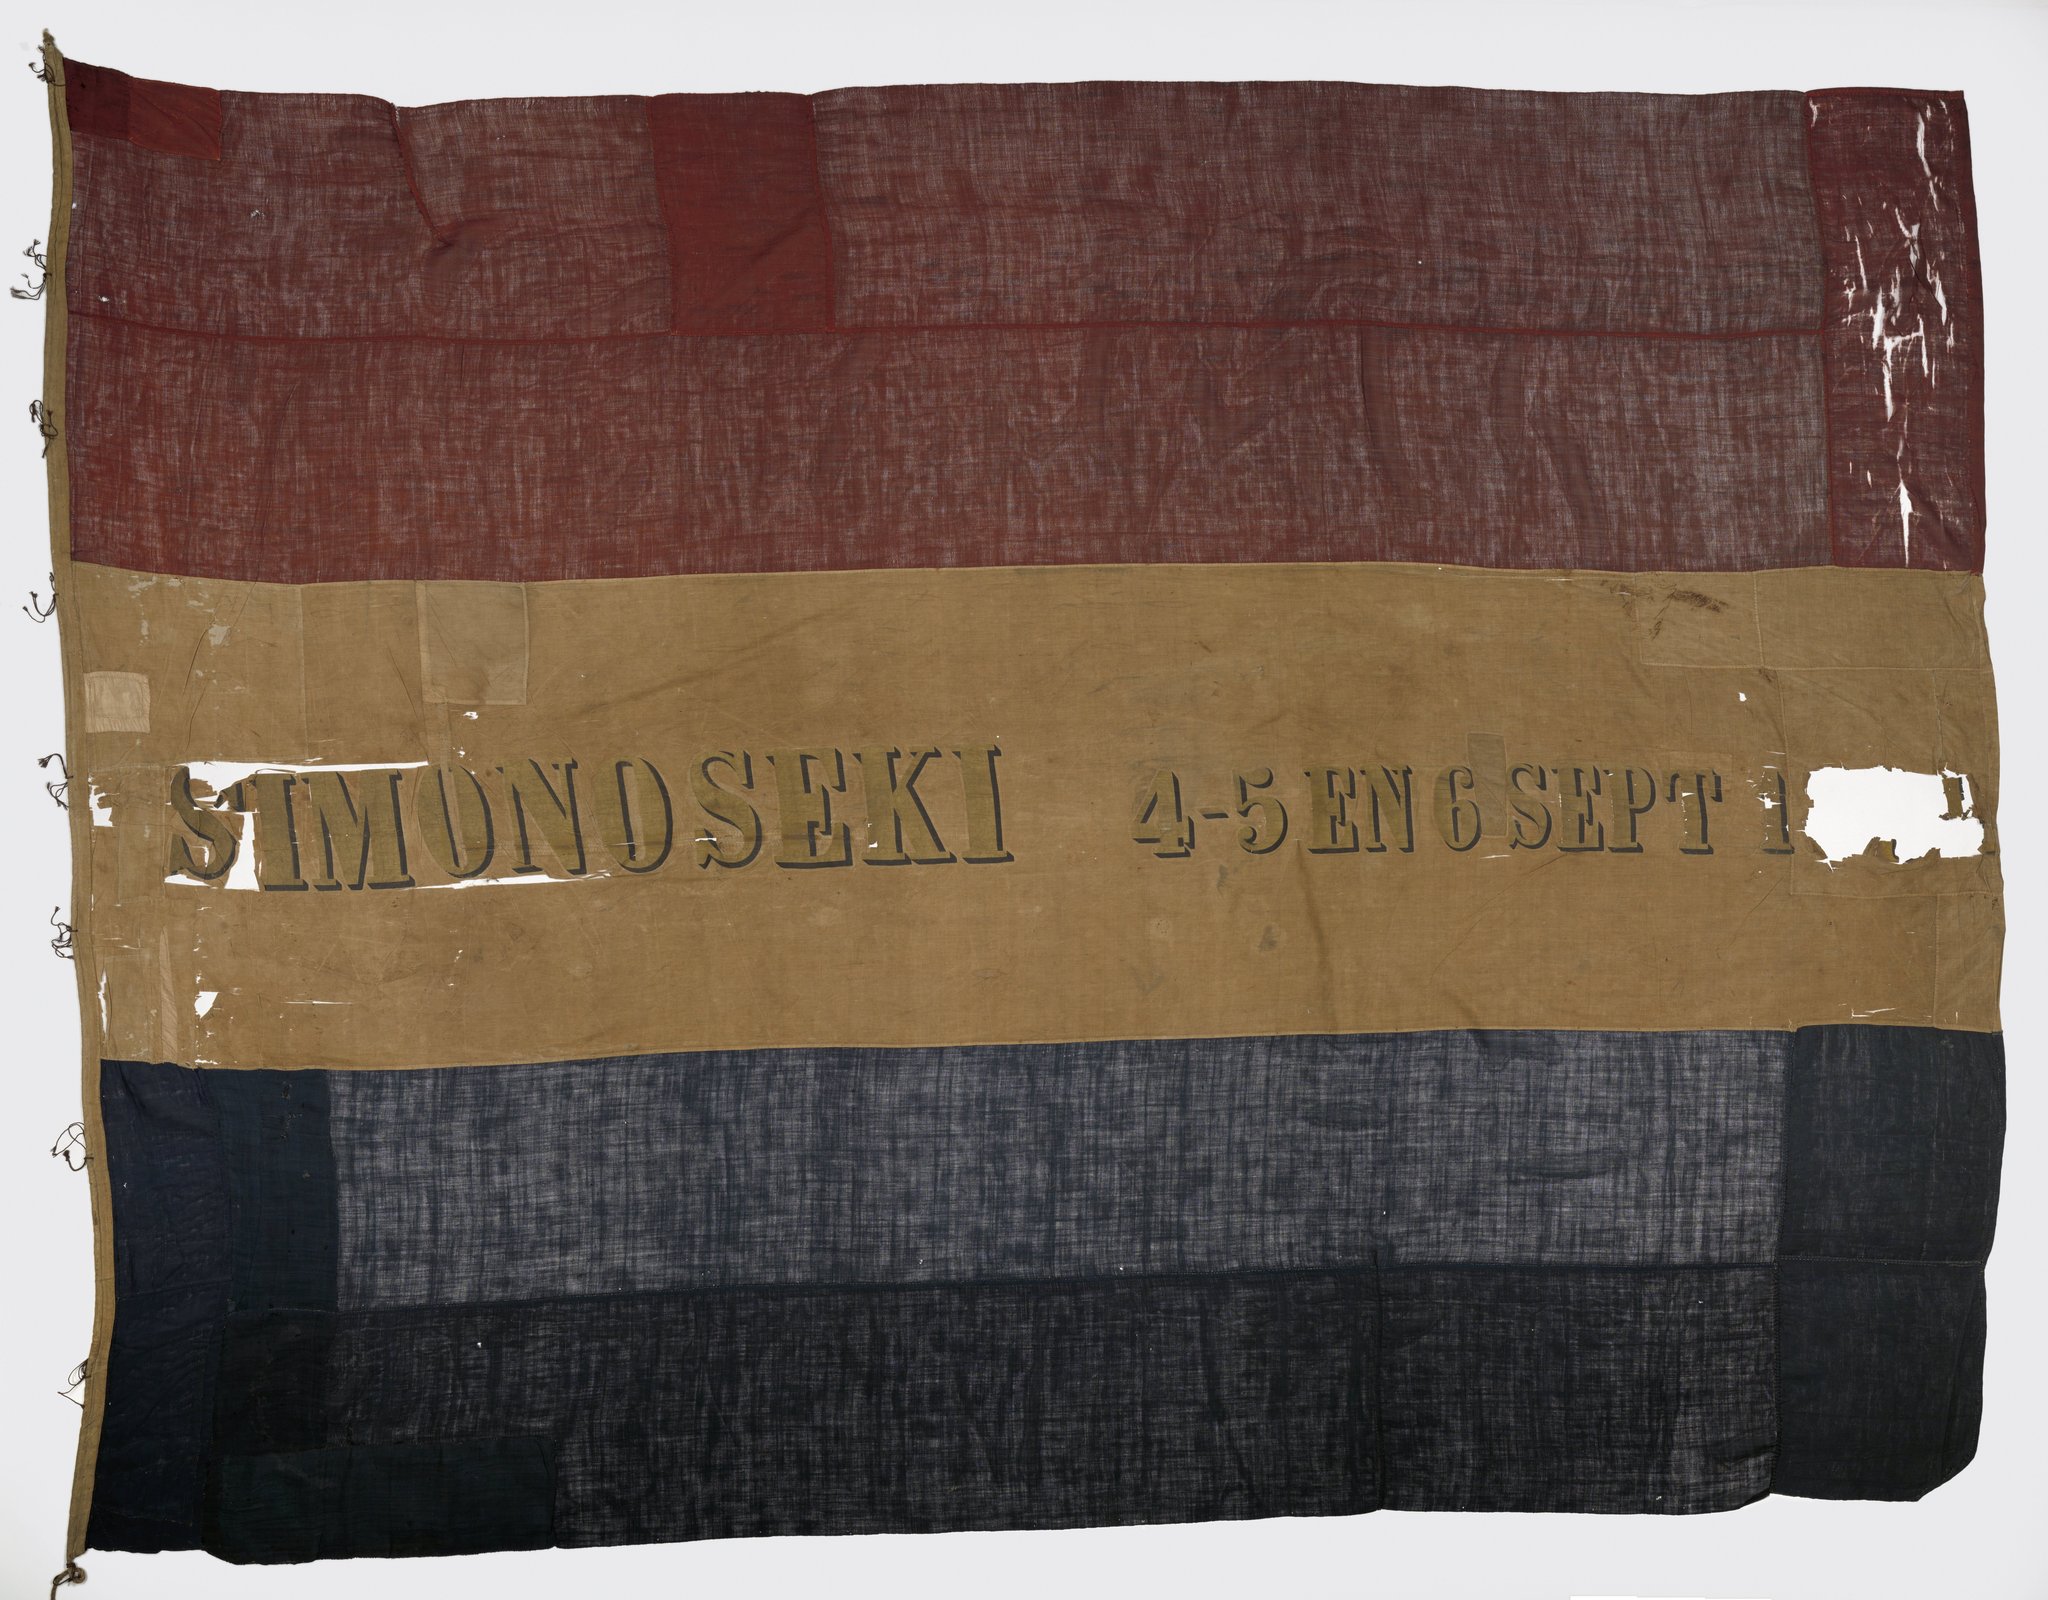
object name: ship flag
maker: Anonymous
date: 1865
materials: cotton, wool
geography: netherlands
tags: willem iii (koning der nederlanden), flag, colours (as symbol of the state, etc.), japan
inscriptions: inscription, centre, on both sides: ‘SIMONOSEKI 4-5 EN 6 SEPT 1864.’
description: Deze vlag werd in 1865 door koning Willem III aan het schroefstoomschip van 16 stukken Djambi (Amsterdam 1858-1860, lang 58 m, verkocht in Simonstad in 1874) aangeboden in waardering voor haar aandeel in de forcering van de Straat van Simonoseki, waarbij het schip deel uitmaakte van een internationale strafexpeditie tegen de Prins van Nagato.